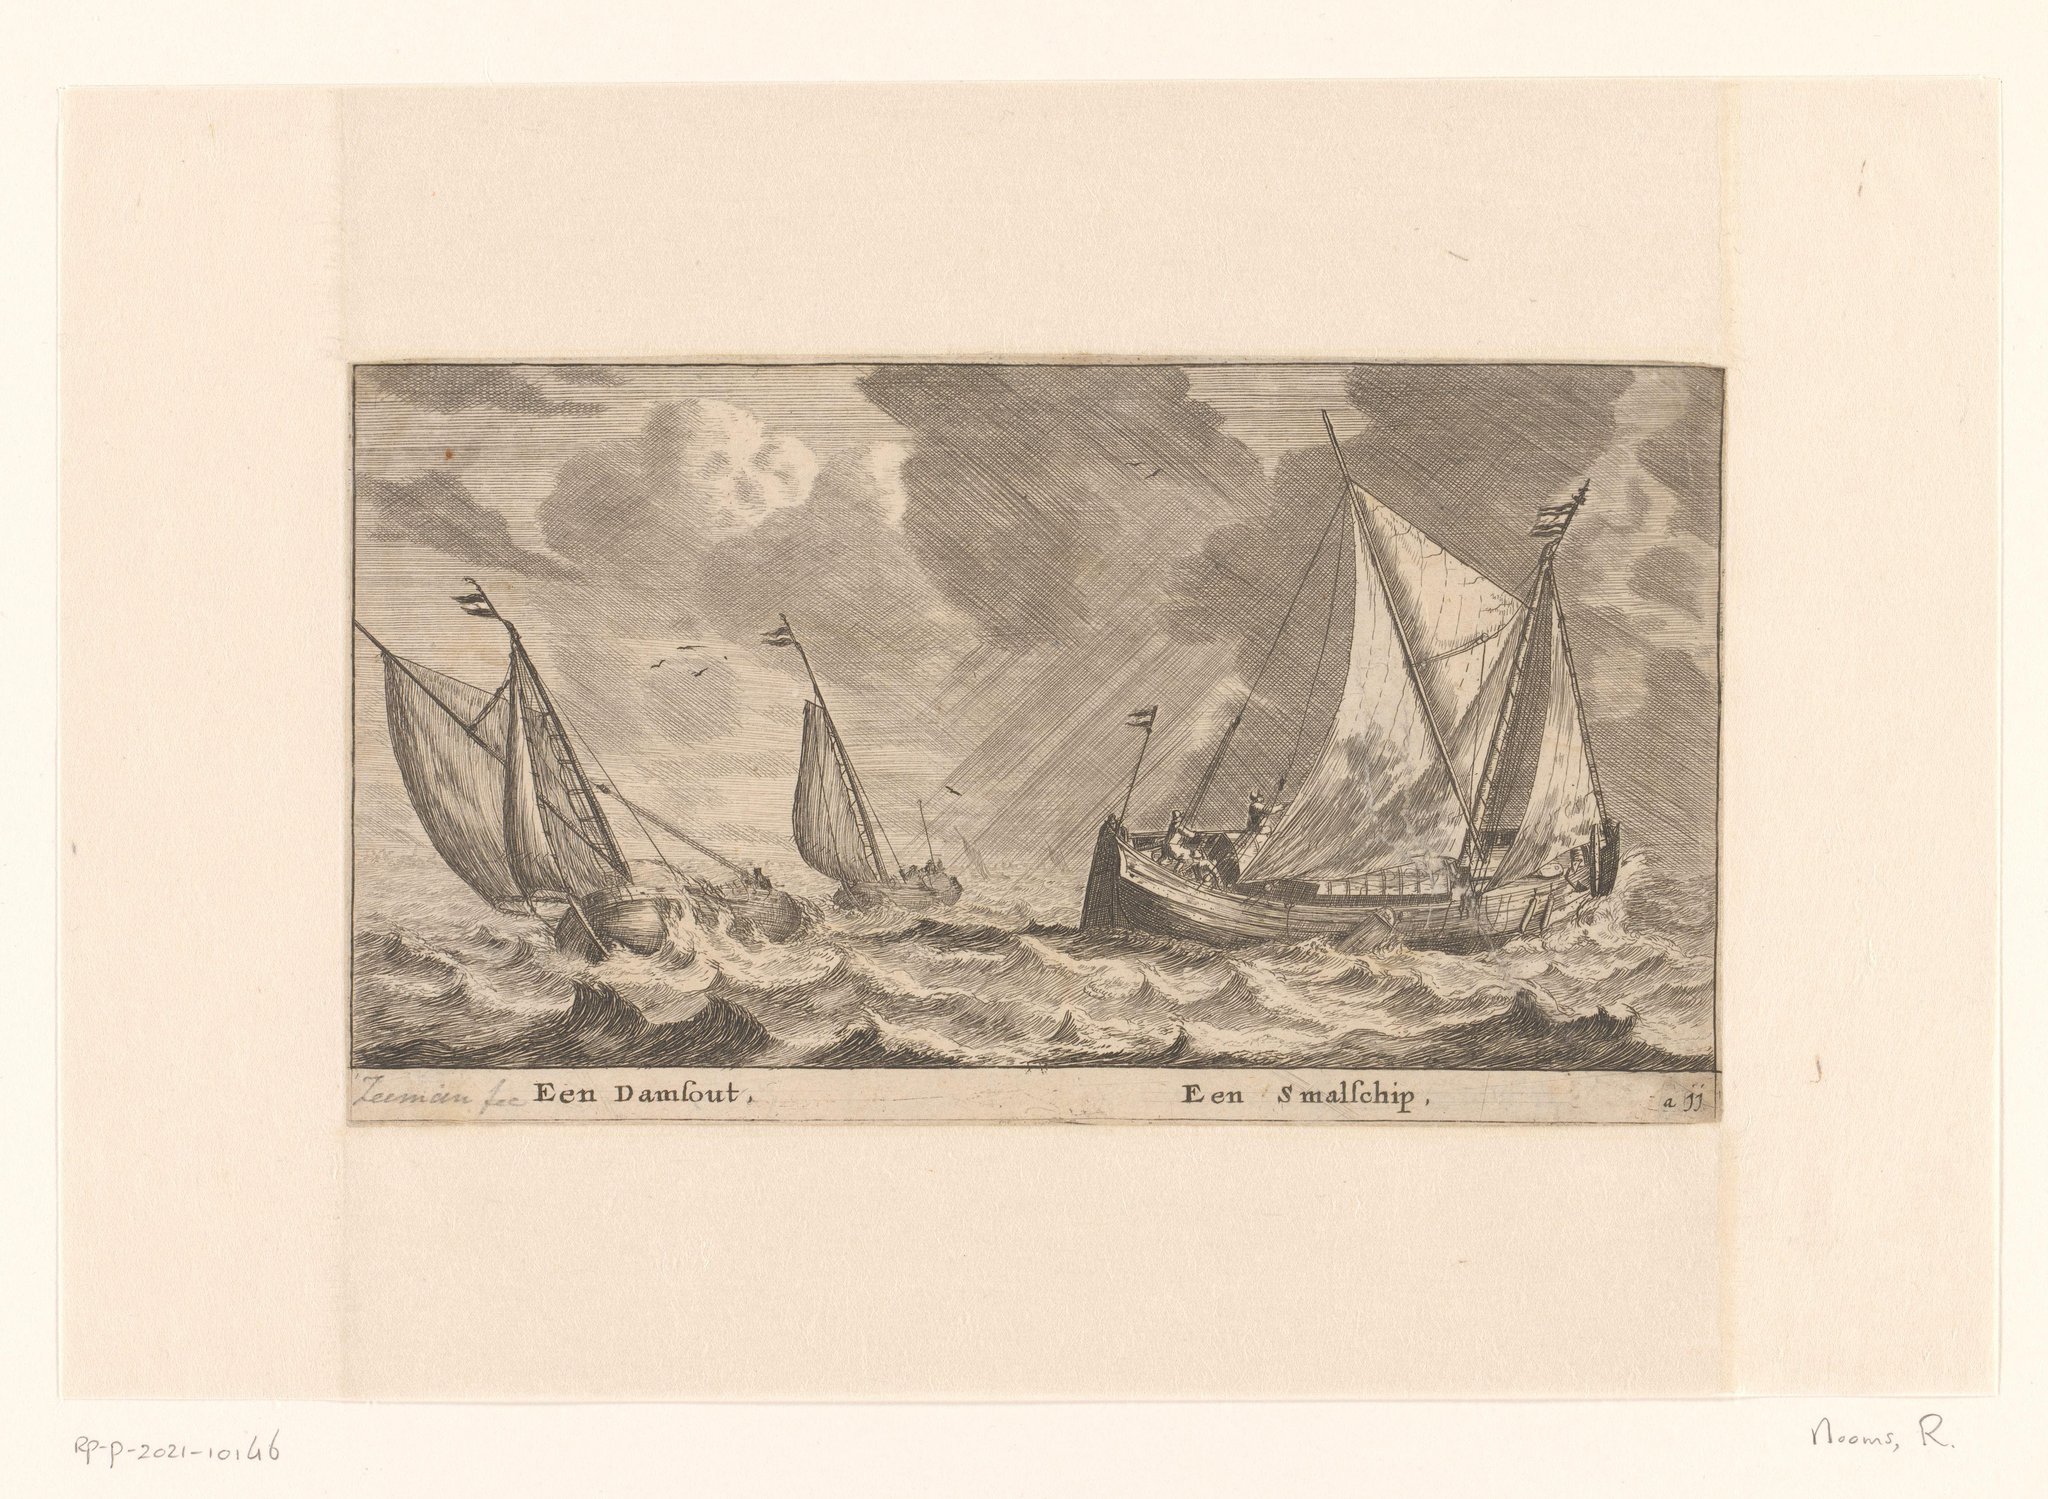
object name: print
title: Verschillende schepen en stadsgezichten van Amsterdam, eerste deel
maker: reinier nooms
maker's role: draughtsman, painter, print maker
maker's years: 1623-1664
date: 1652-1654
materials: paper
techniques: drypoint, etching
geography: northern netherlands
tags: sailing-ship, sailing-boat (with name)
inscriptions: collector's mark: Lugt 1425